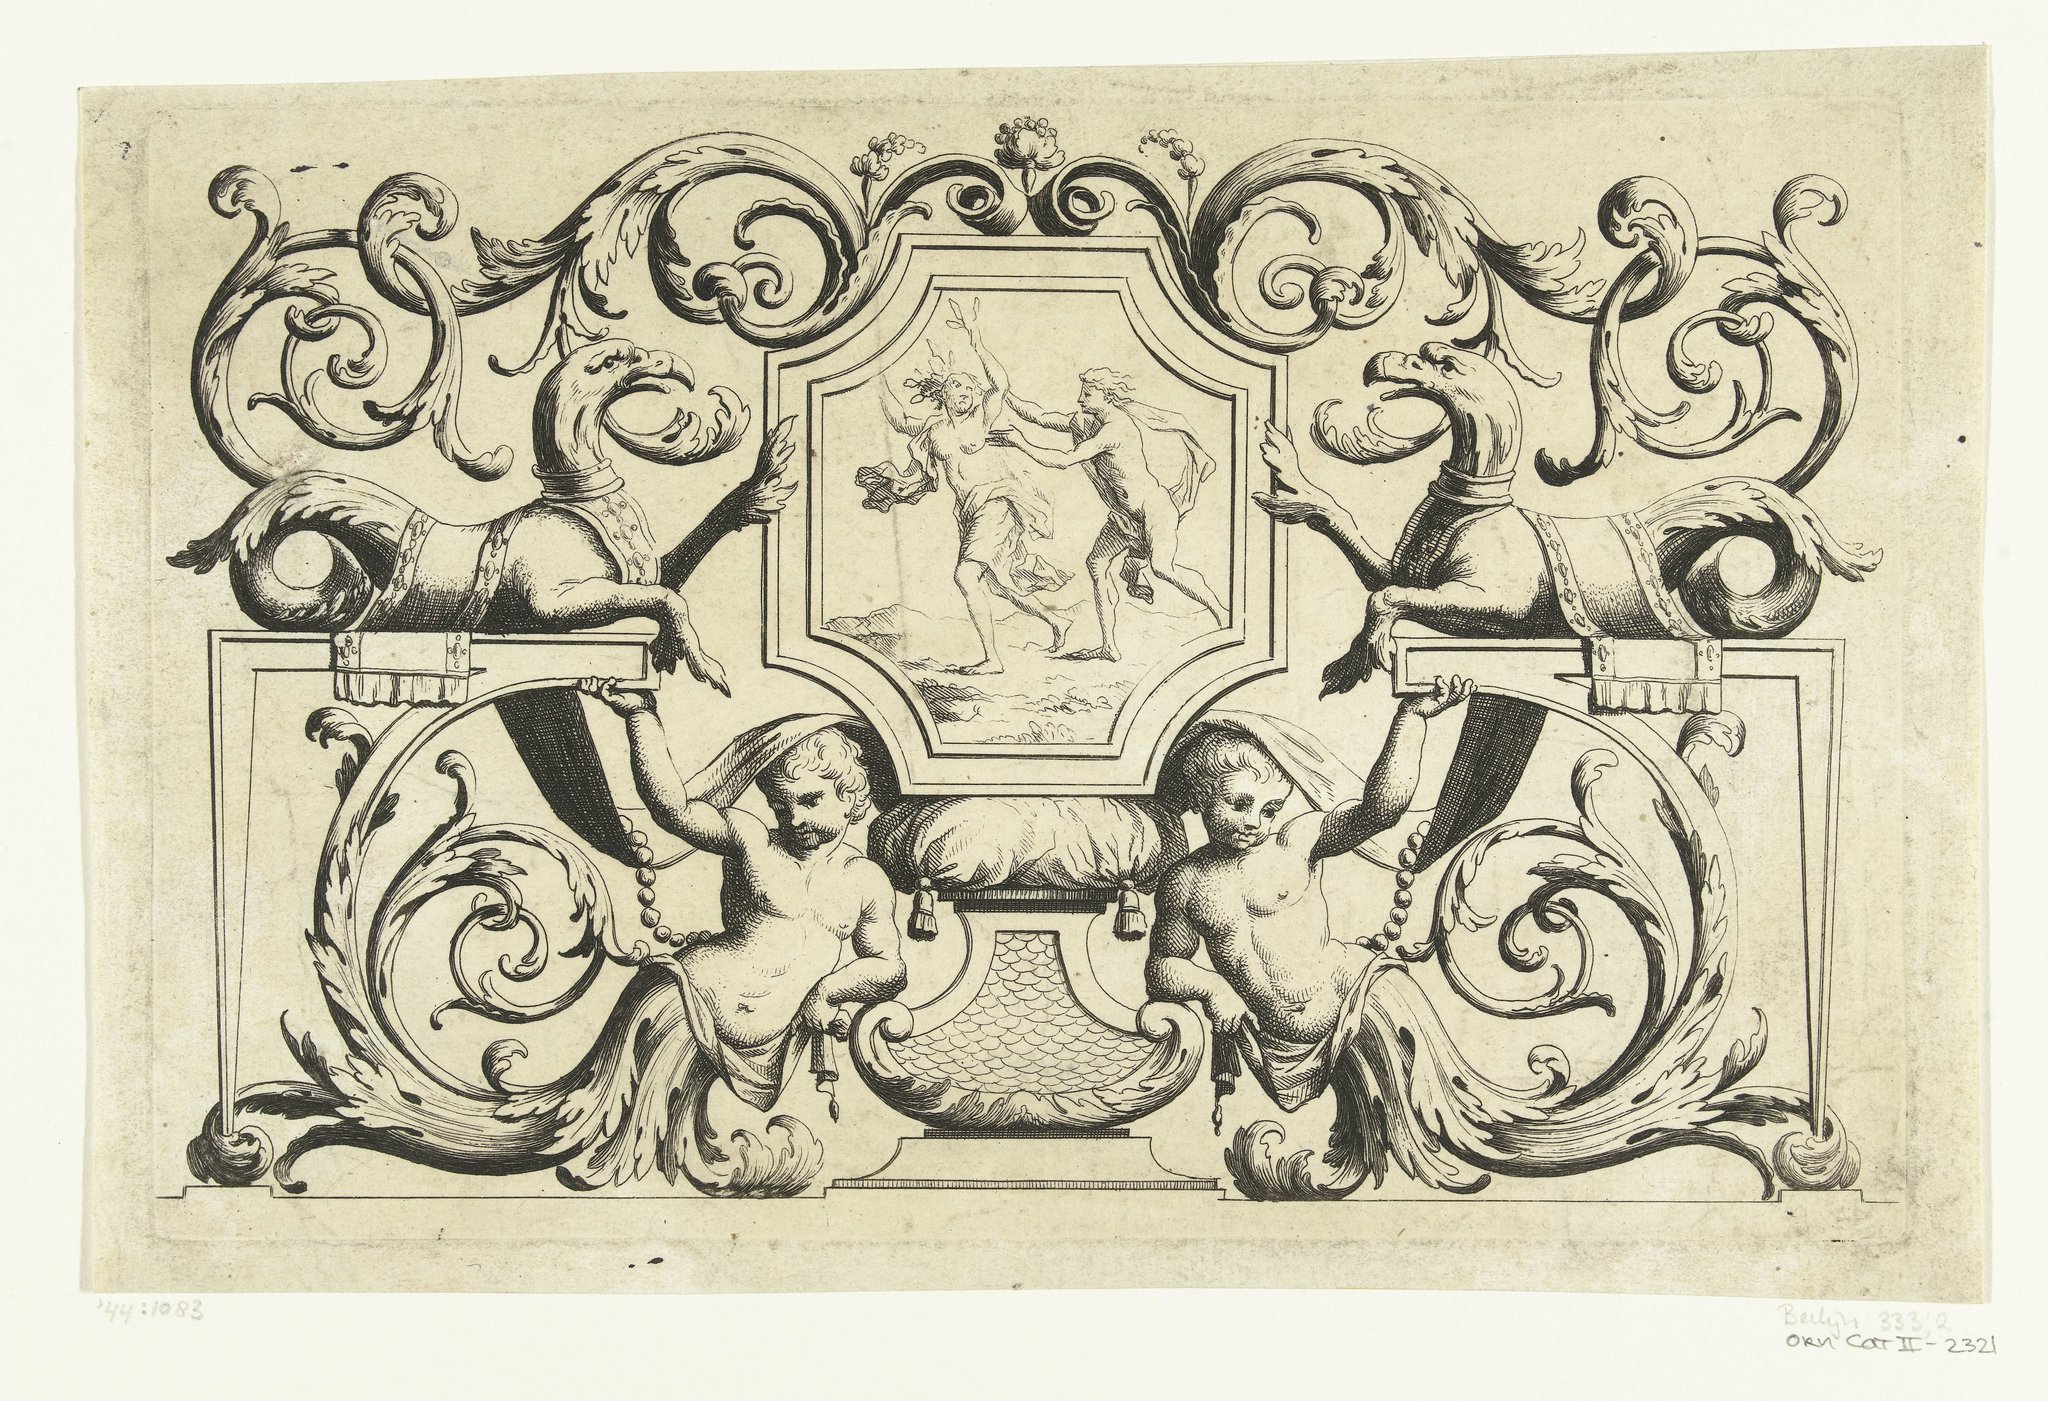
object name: ornament print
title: Nouueaux desseins d'Ornemens pour lembellissment des carosses, Paneaux, Lambris &c.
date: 1634-1716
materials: paper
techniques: etching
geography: france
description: Het paneel rust op een kussen temidden van twee kinderen die ontspruiten uit bladranken. Blad 3 uit serie van 6 bladen met ornamenten voor versiering van koetsen.